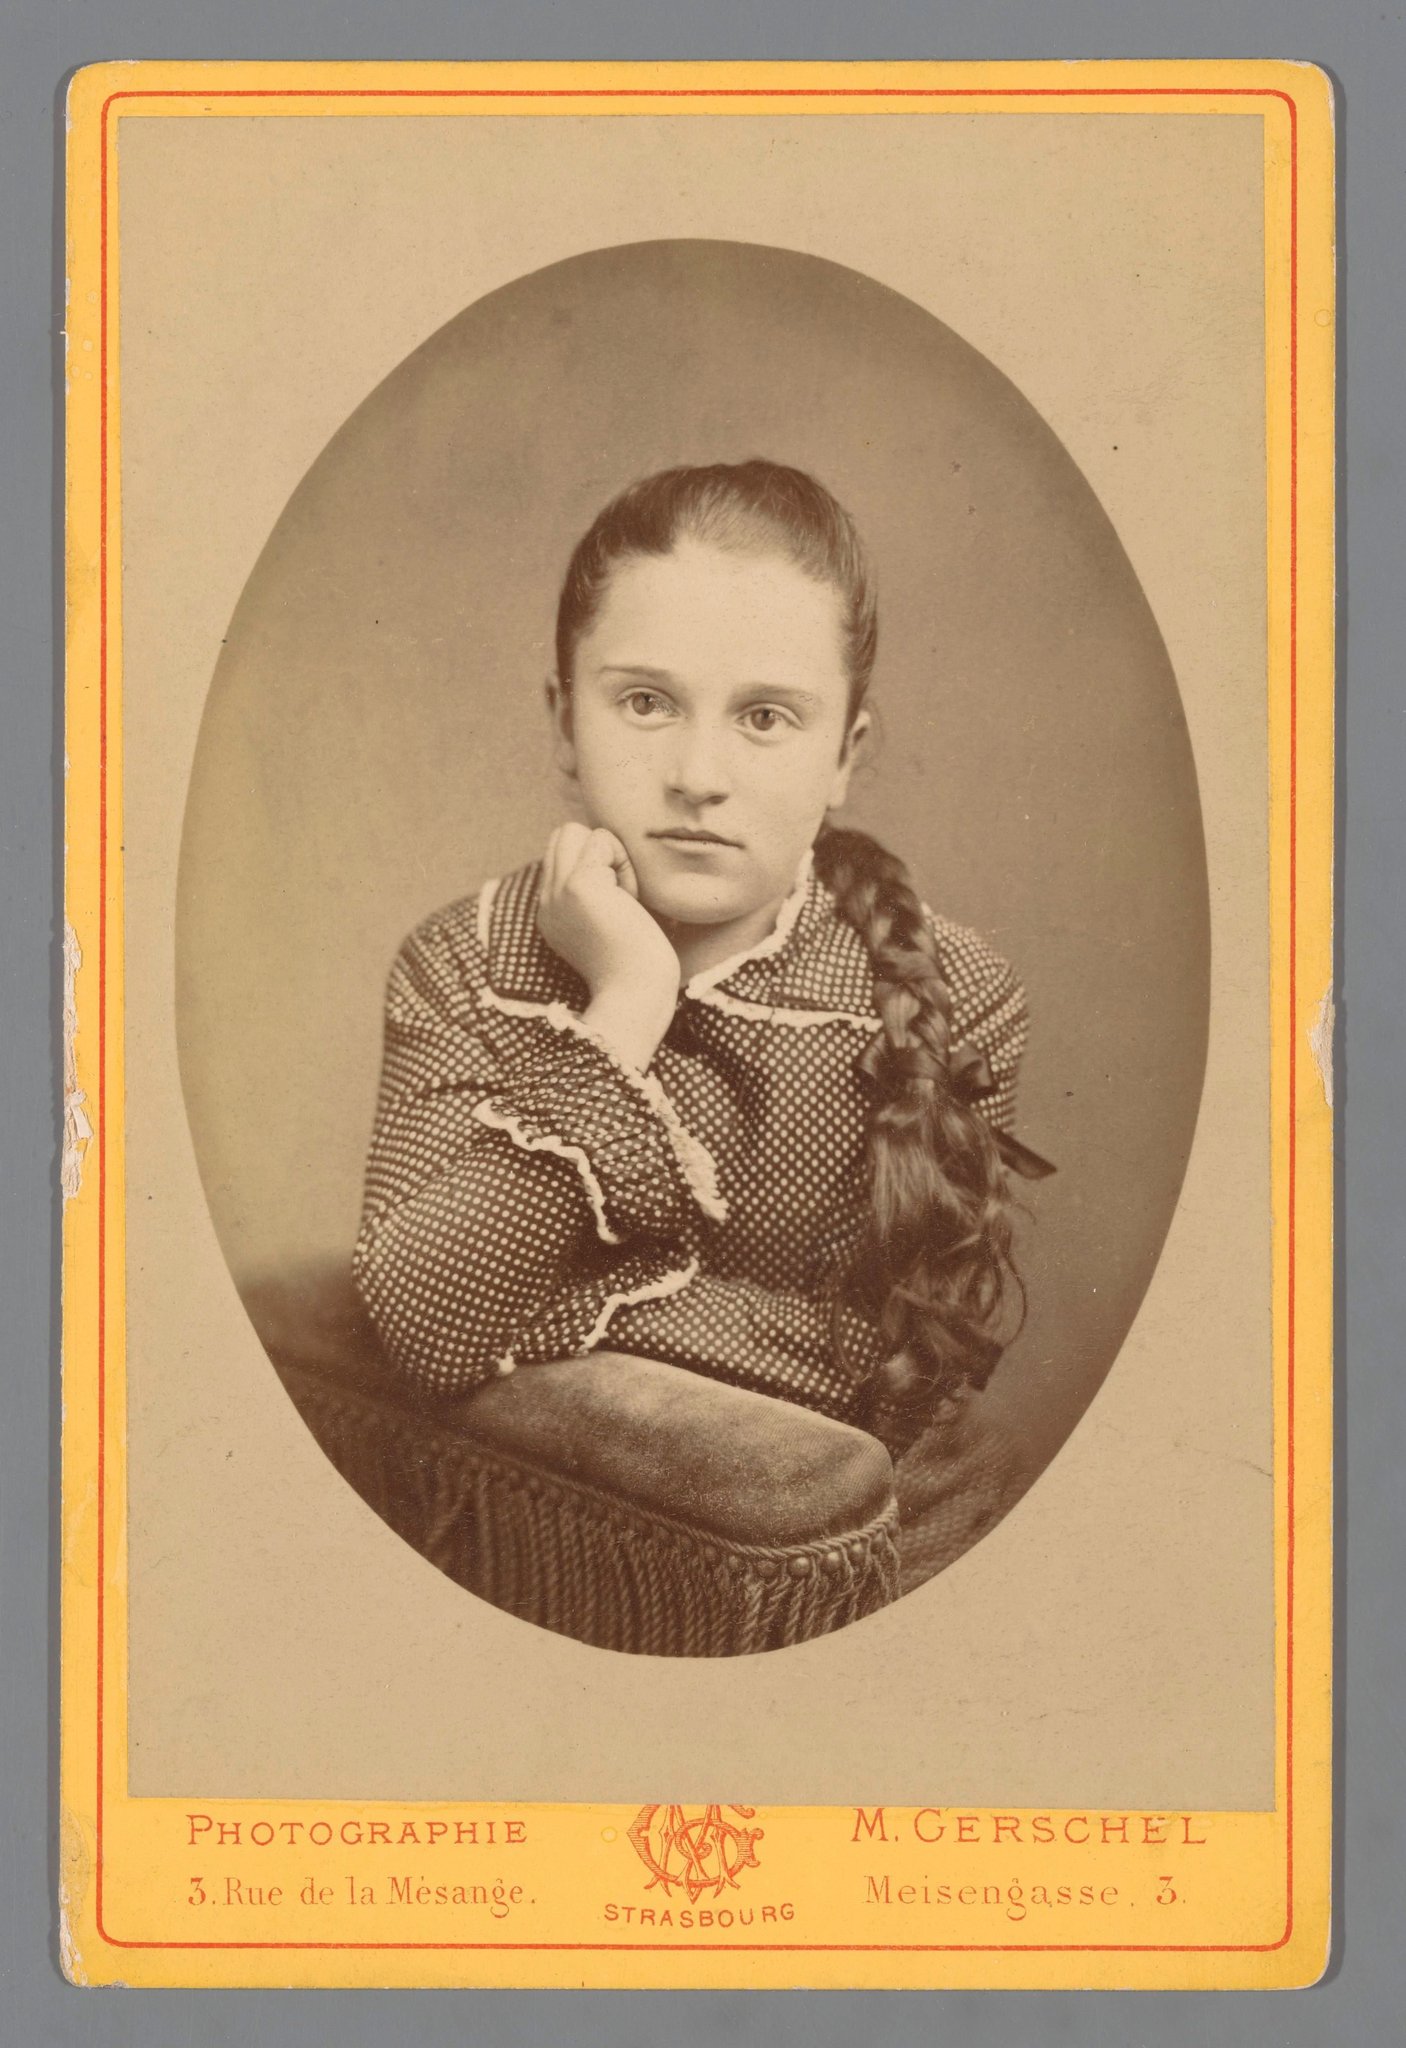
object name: cabinet photograph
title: Portret van een meisje leunend op stoel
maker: mathias gerschel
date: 1880-1900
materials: cardboard, photographic support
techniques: albumen print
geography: straatsburg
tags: child (at home) - aa - girl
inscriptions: name: ‘Maison Gerschel Frères M. Gerschel 3. Rue de la Mésange. 3. Meisengasse 3. Maison du Café de la Mésange Im Hause Kaffe zur Meise Strasbourg.’